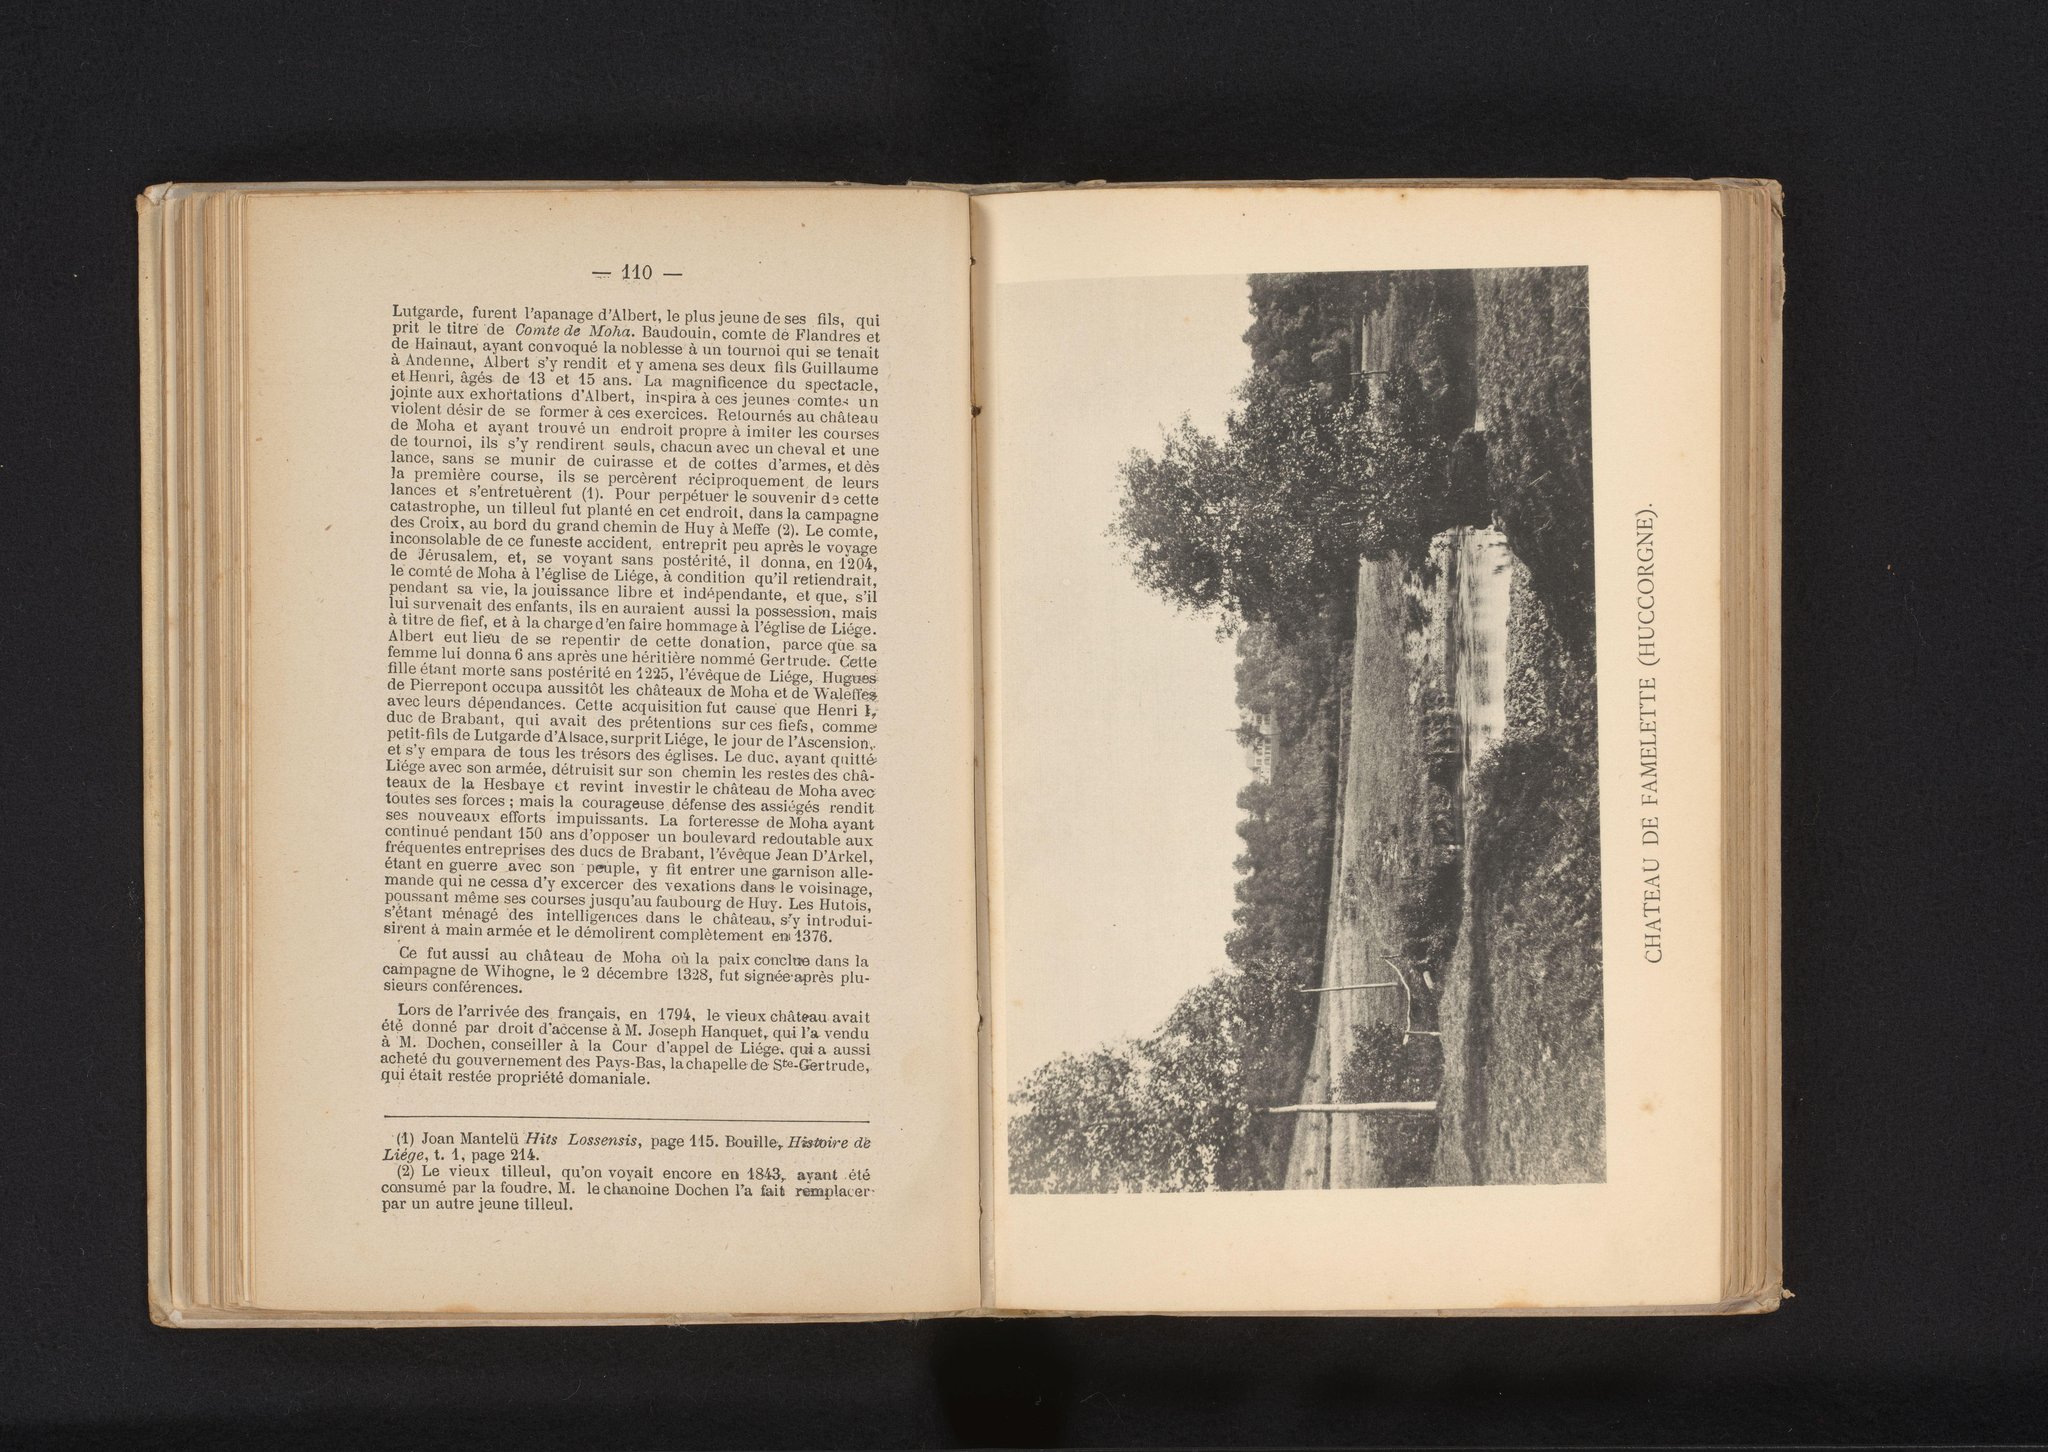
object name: photomechanical print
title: Landschap met Château de Famelette te Huccorgne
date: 1885-1890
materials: paper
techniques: photograph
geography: brussels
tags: landscape with tower or castle